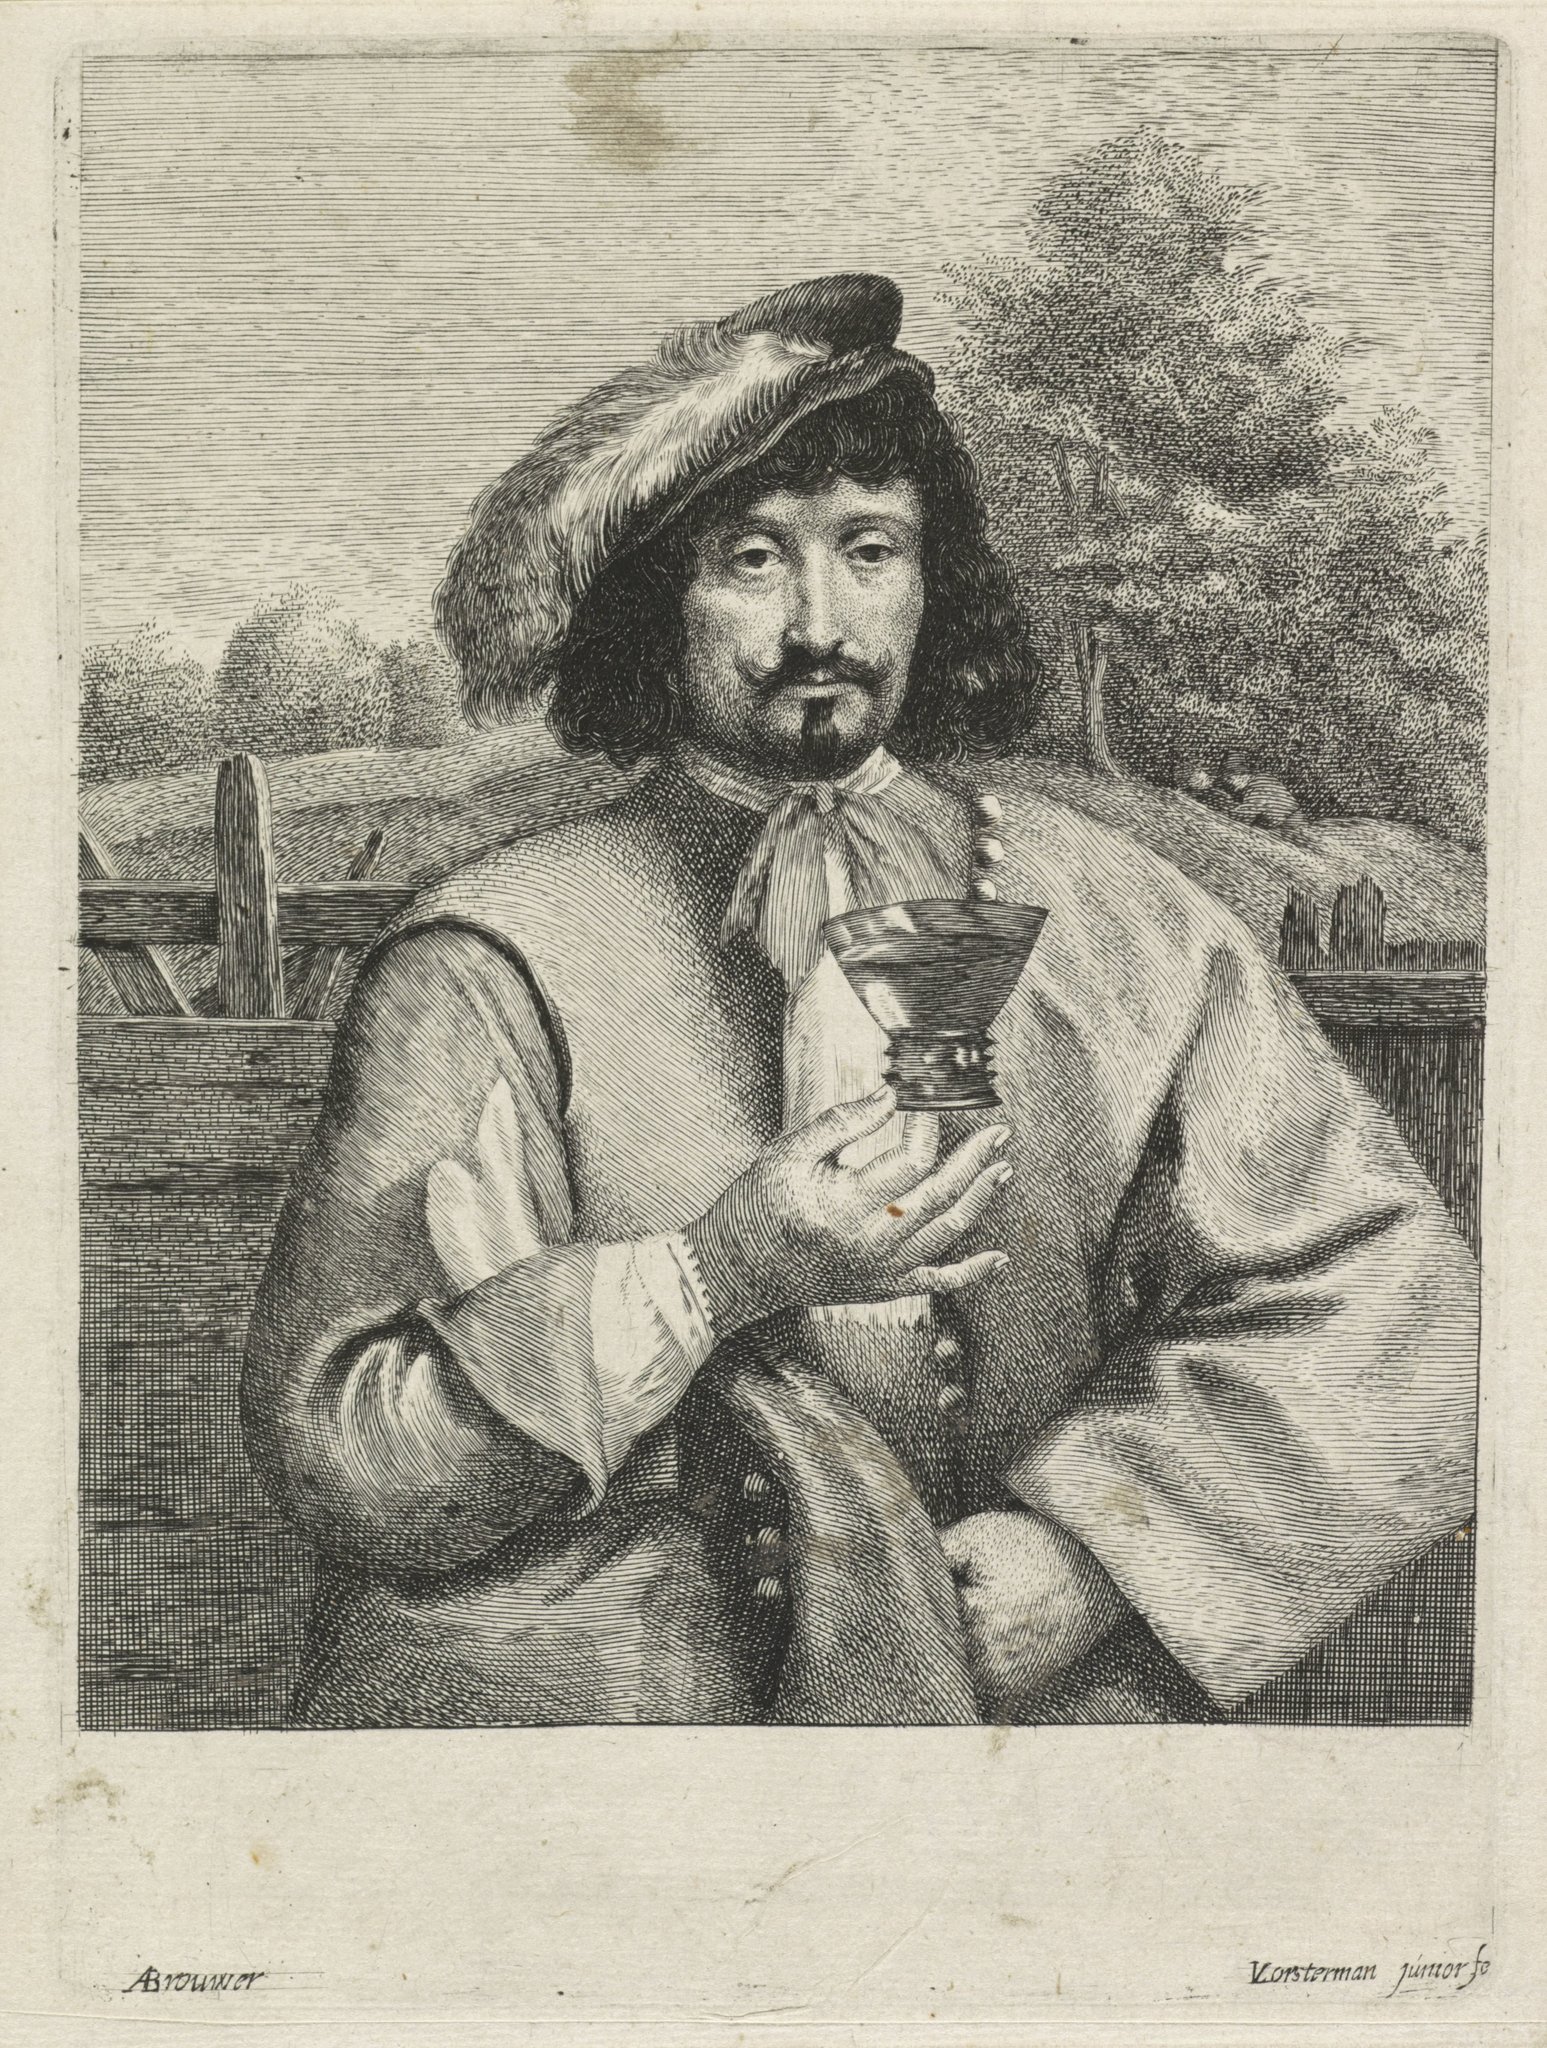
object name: print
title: Man met een wijnglas (Luxuria)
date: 1651-1652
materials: paper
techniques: engraving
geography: antwerp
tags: lust, luxury, 'luxuria'; 'lussuria' (ripa) ~ personification of one of the deadly sins, glass, rummer, glass of wine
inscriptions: collector's mark: Lugt 240